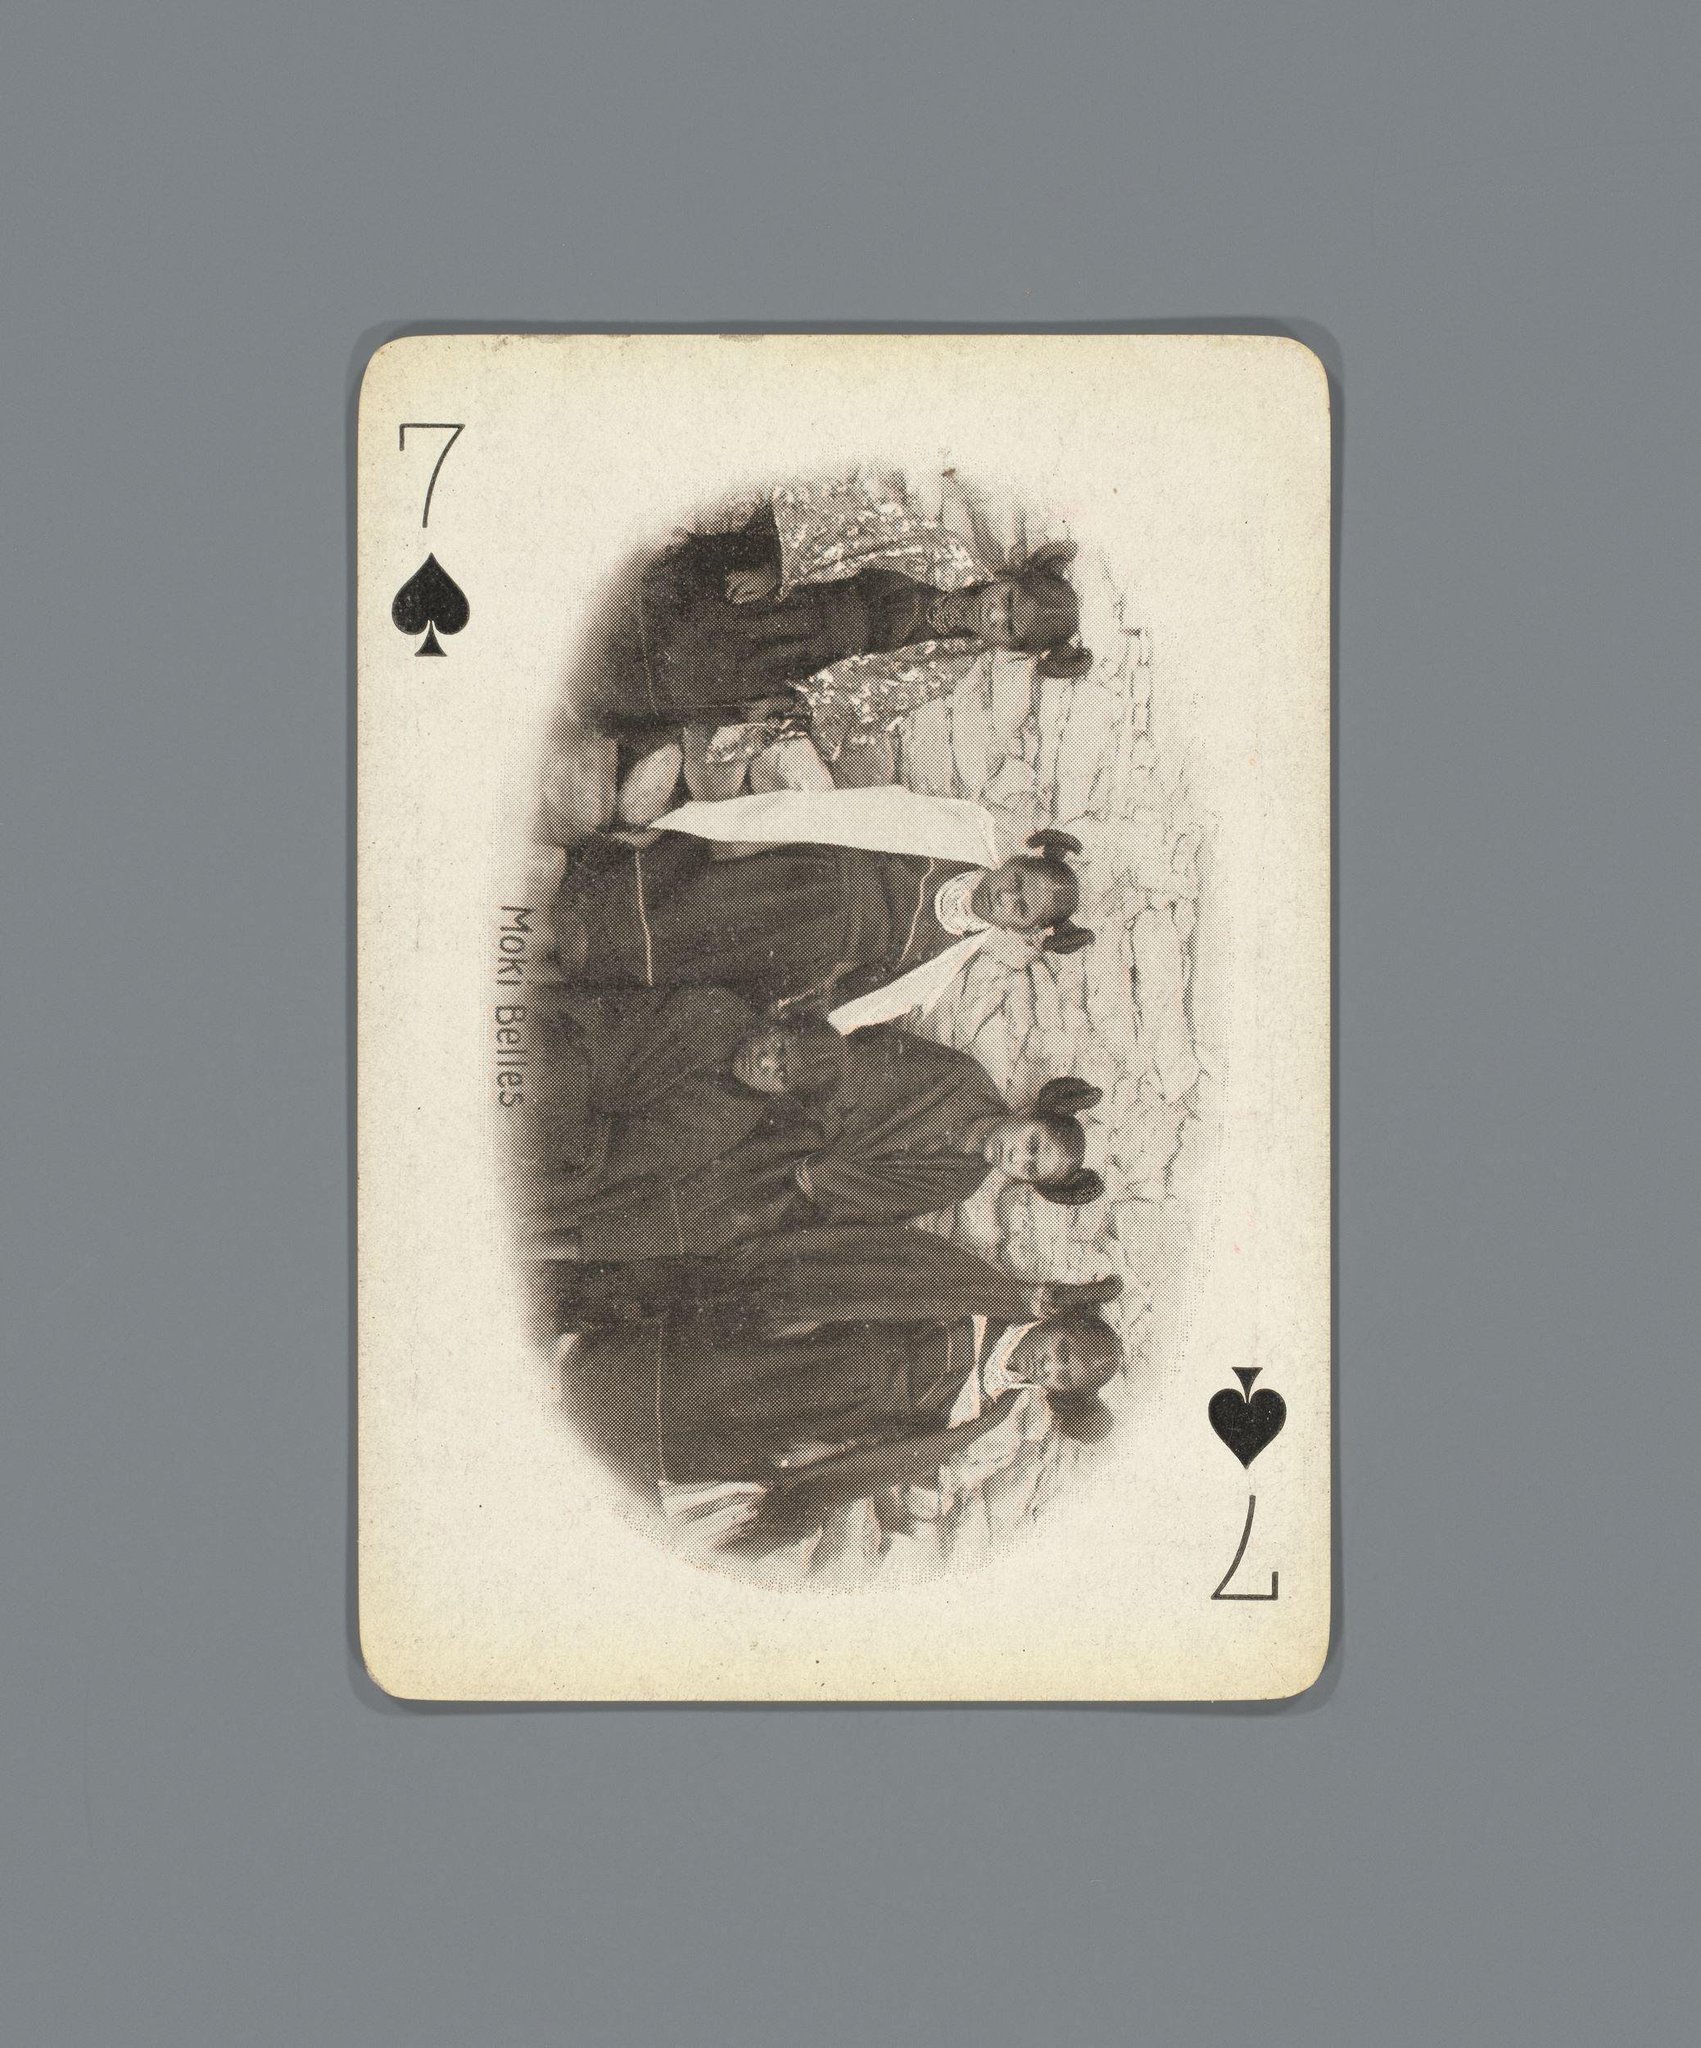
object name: playing card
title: Moki Belles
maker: adam clark vroman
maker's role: fotograaf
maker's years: 1856-1916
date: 1900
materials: paper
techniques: autotype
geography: united states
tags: arizona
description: Speelkaart uit doosje met 53 speelkaarten met afbeeldingen in autotypie van Native Americans. De inhoud bevat een complete set speelkaarten inclusief joker.